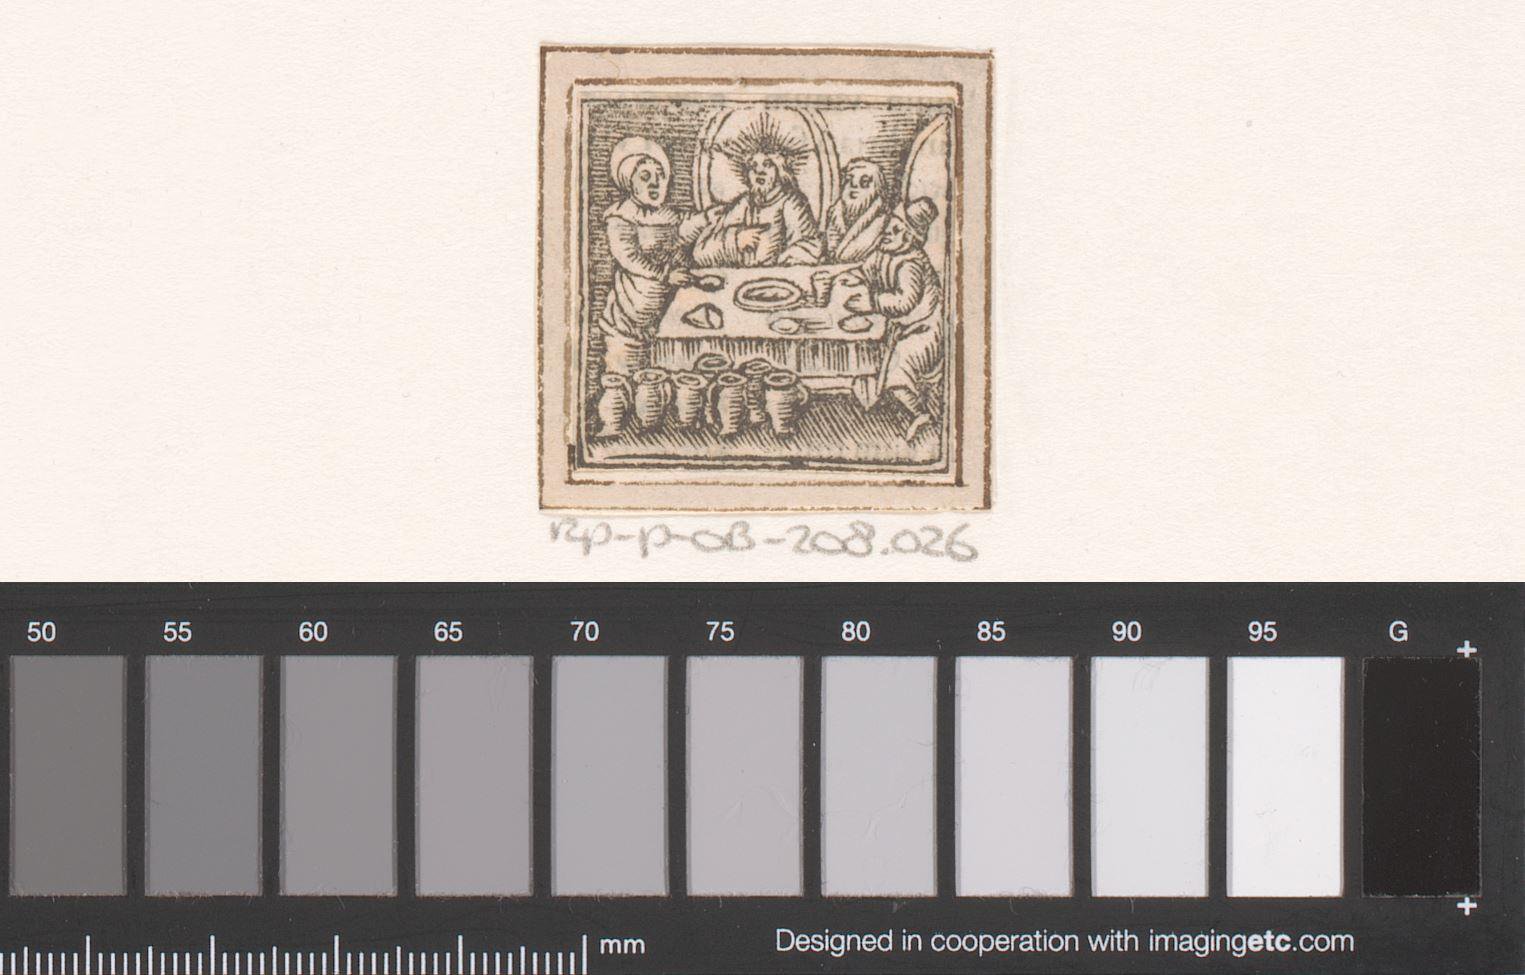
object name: print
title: Emmaüsgangers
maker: Anonymous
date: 1600-1699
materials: paper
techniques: woodcut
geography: netherlands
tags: the supper at emmaus: christ is recognized while blessing or breaking the bread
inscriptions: collector's mark: Lugt 2228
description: Christus zit samen met twee discipelen aan tafel in het dorp Emmaüs.